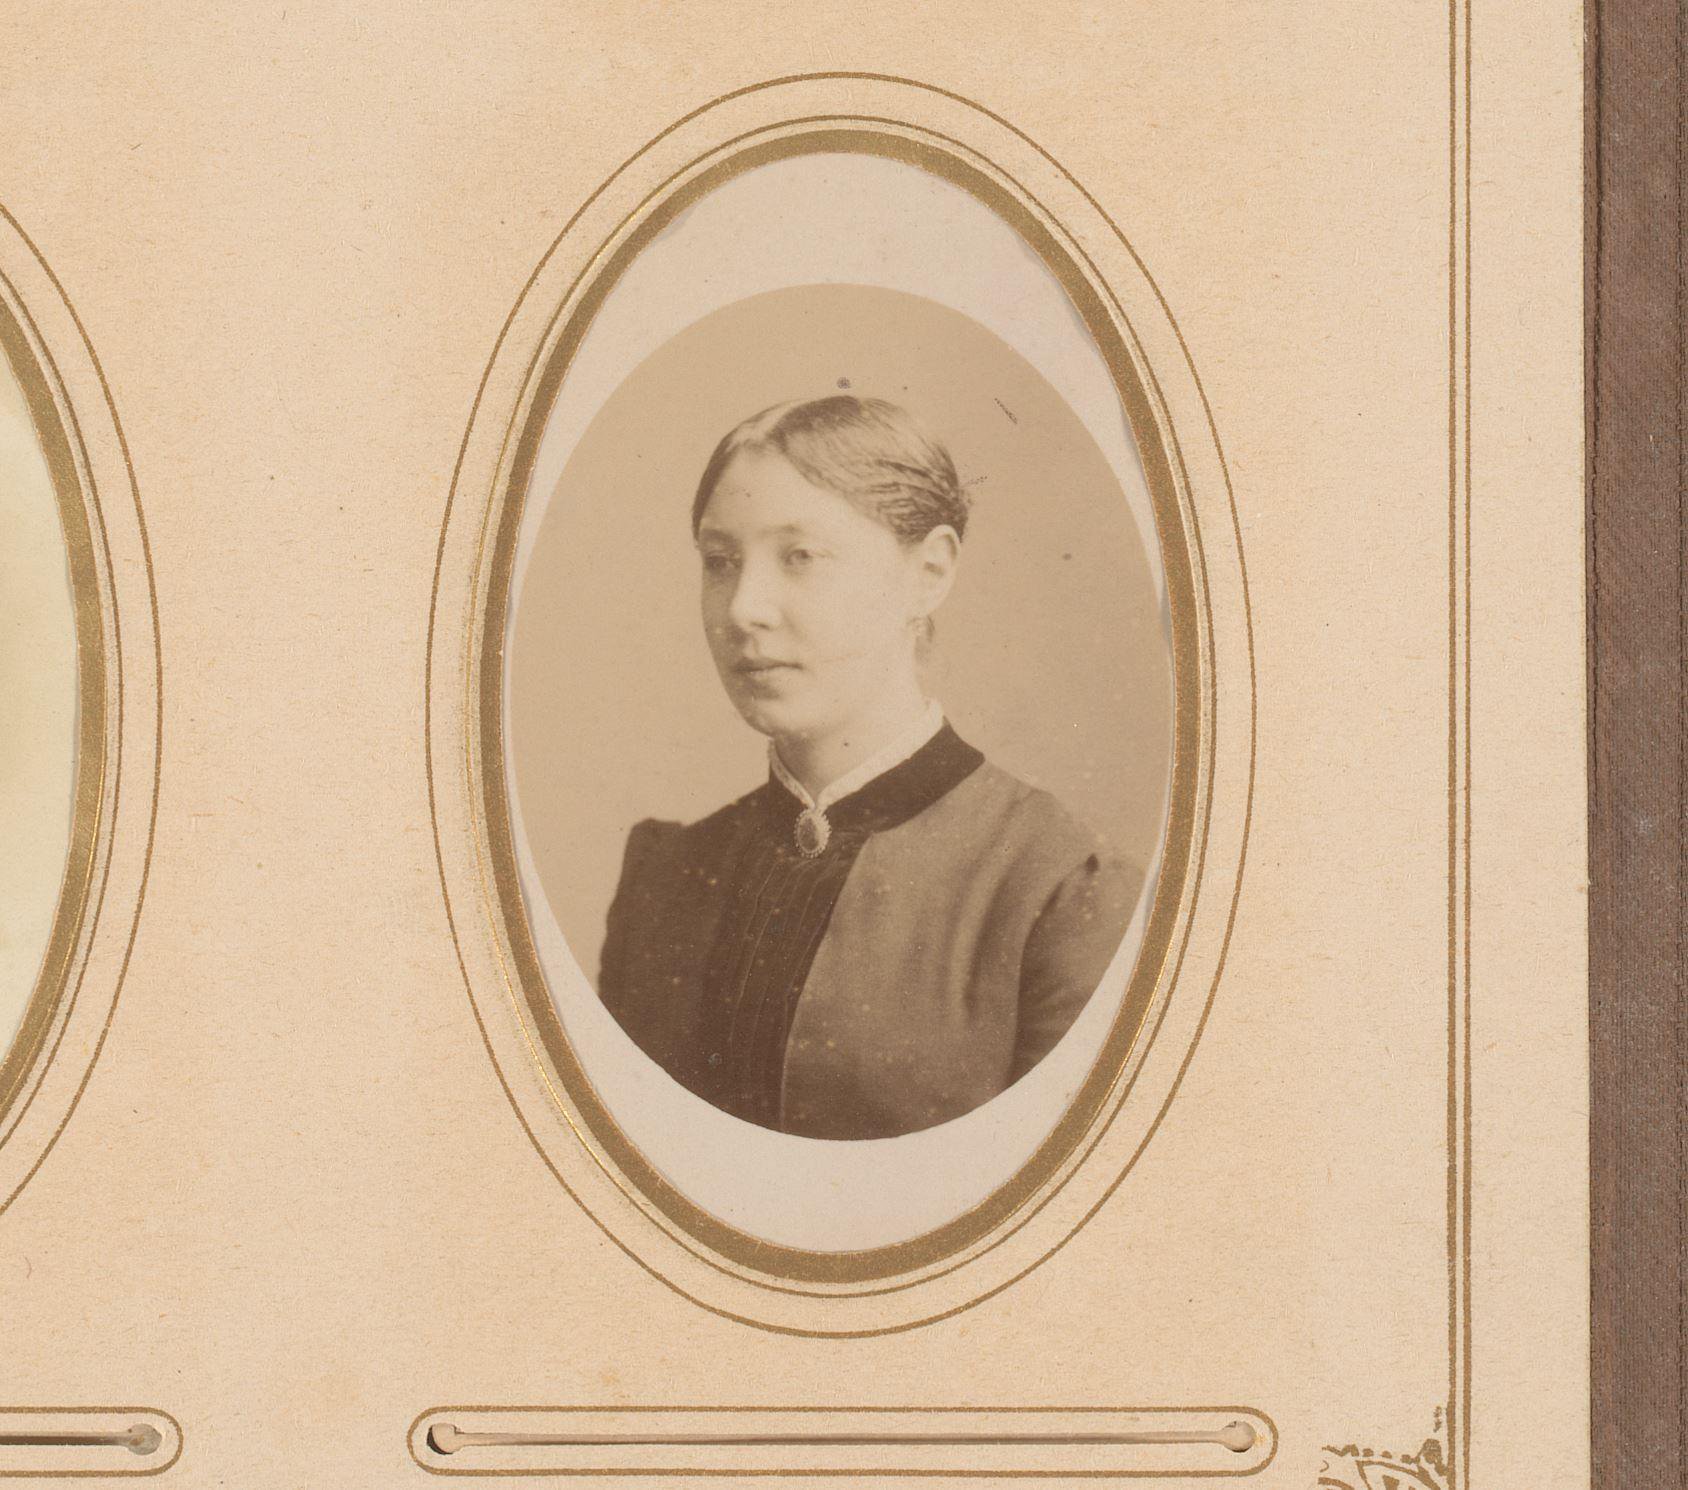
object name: album leaf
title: Portret van een jonge vrouw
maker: albert greiner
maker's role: fotograaf, fotostudio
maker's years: 1833-1890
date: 1887-1890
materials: cardboard, photographic support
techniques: albumen print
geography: amsterdam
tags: adolescent, young woman, maiden, historical persons - bb - woman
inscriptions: inscription: ‘Albert Greiner/ KON. NED. HOF-PHOTOGRAAF/ Amsterdam/ Damrak 24/ Specialiteit in Vergrootingen.’